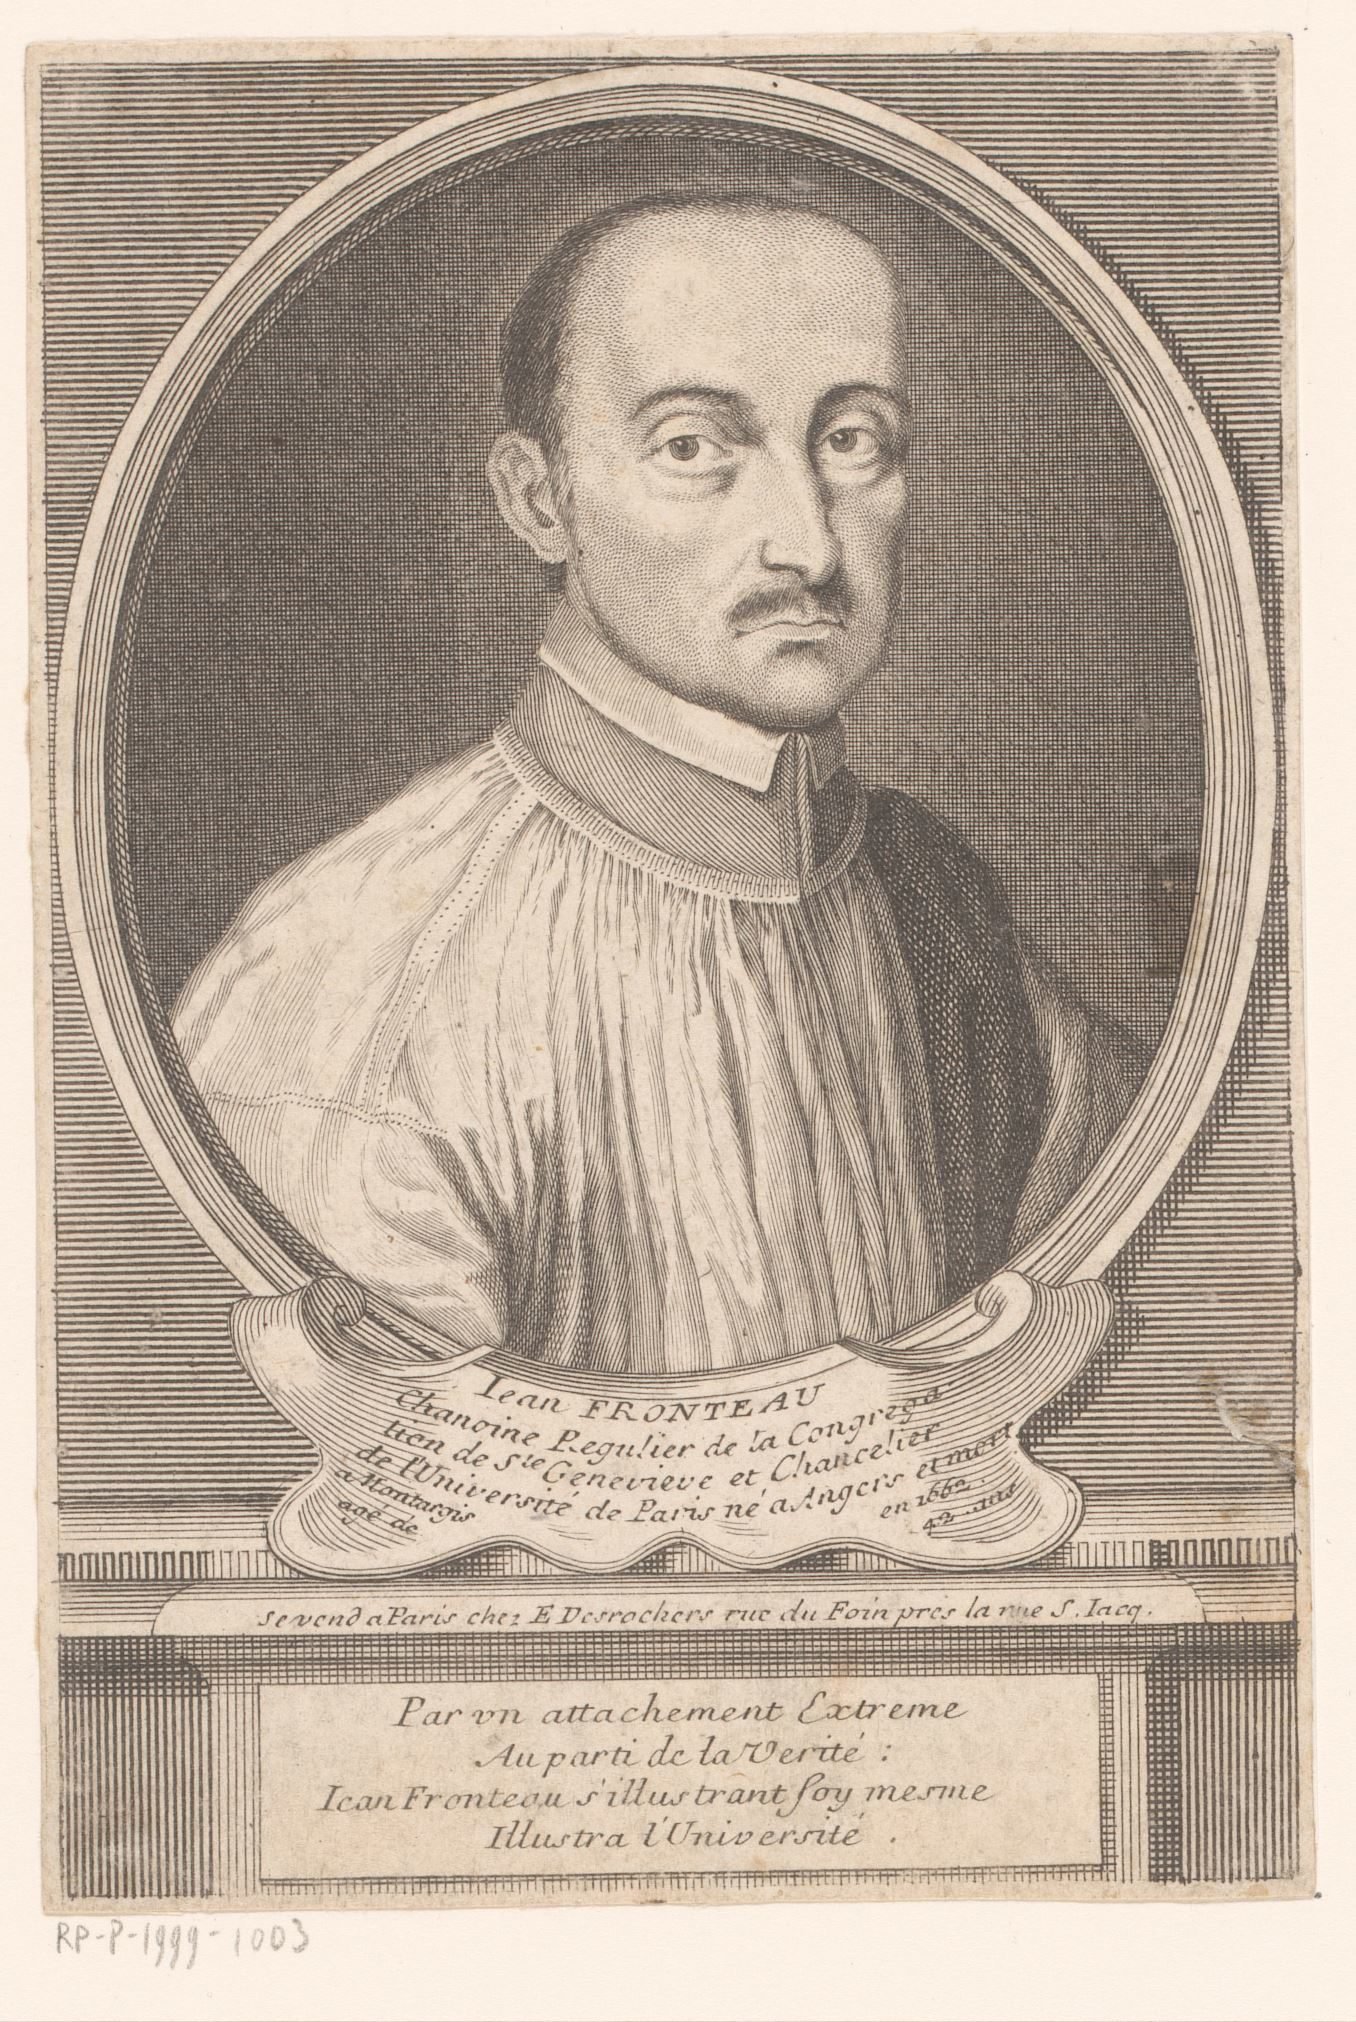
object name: print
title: Verzameling portretten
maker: étienne desrochers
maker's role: print maker, publisher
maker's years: 1668-1741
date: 1726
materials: paper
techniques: engraving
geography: paris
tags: clergyman, historical persons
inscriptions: collector's mark: Lugt 2228, collector's mark: Lugt 2760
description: Behoort waarschijnlijk tot een serie portretten, grotendeels door Etienne Desrochers, getiteld: 'Recueil de portraits de personnes qui se sont distinguées tant dans les Armes que dans Belles-Lettres et les Arts, comme aussi la famille royale de France et autres cours étrangères'. De serie werd initieel uitgegeven door Desrochers en aangekondigd in 'Mercure' in mei 1726, p. 985. Echter was Desrochers reeds enkele jaren eerder begonnen met het uitgeven van de serie. Na de dood van Desrochers werd de serie voortgezet door Gilles Edme Petit. Een latere staat werd uitgegeven door Jean François Daumont in Parijs.